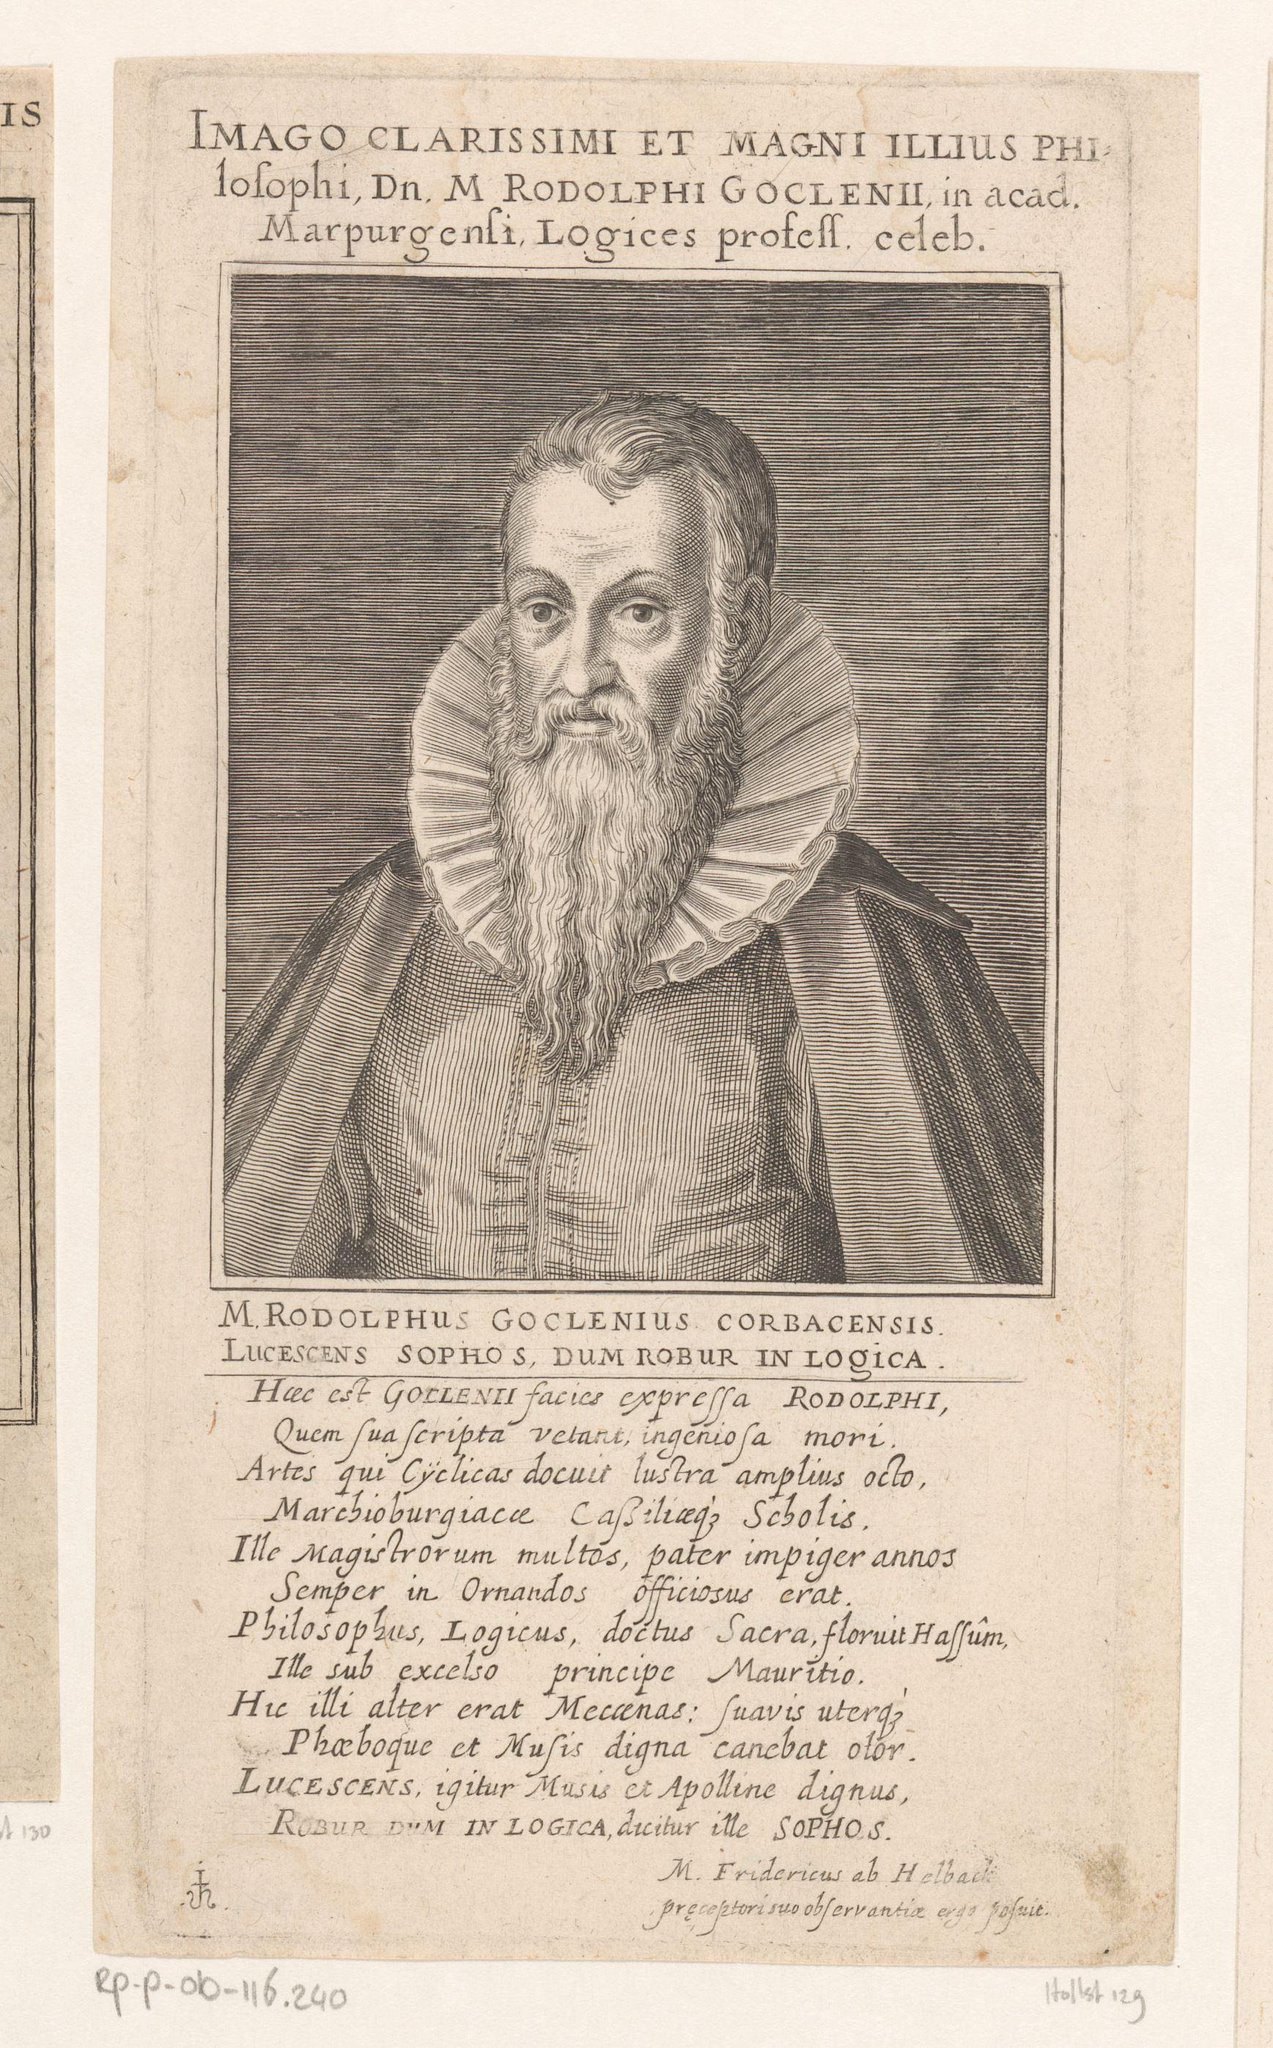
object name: print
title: Portret van Rudolf Göckel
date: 1583-1645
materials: paper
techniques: engraving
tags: scholar, philosopher, historical persons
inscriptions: collector's mark: Lugt 2228